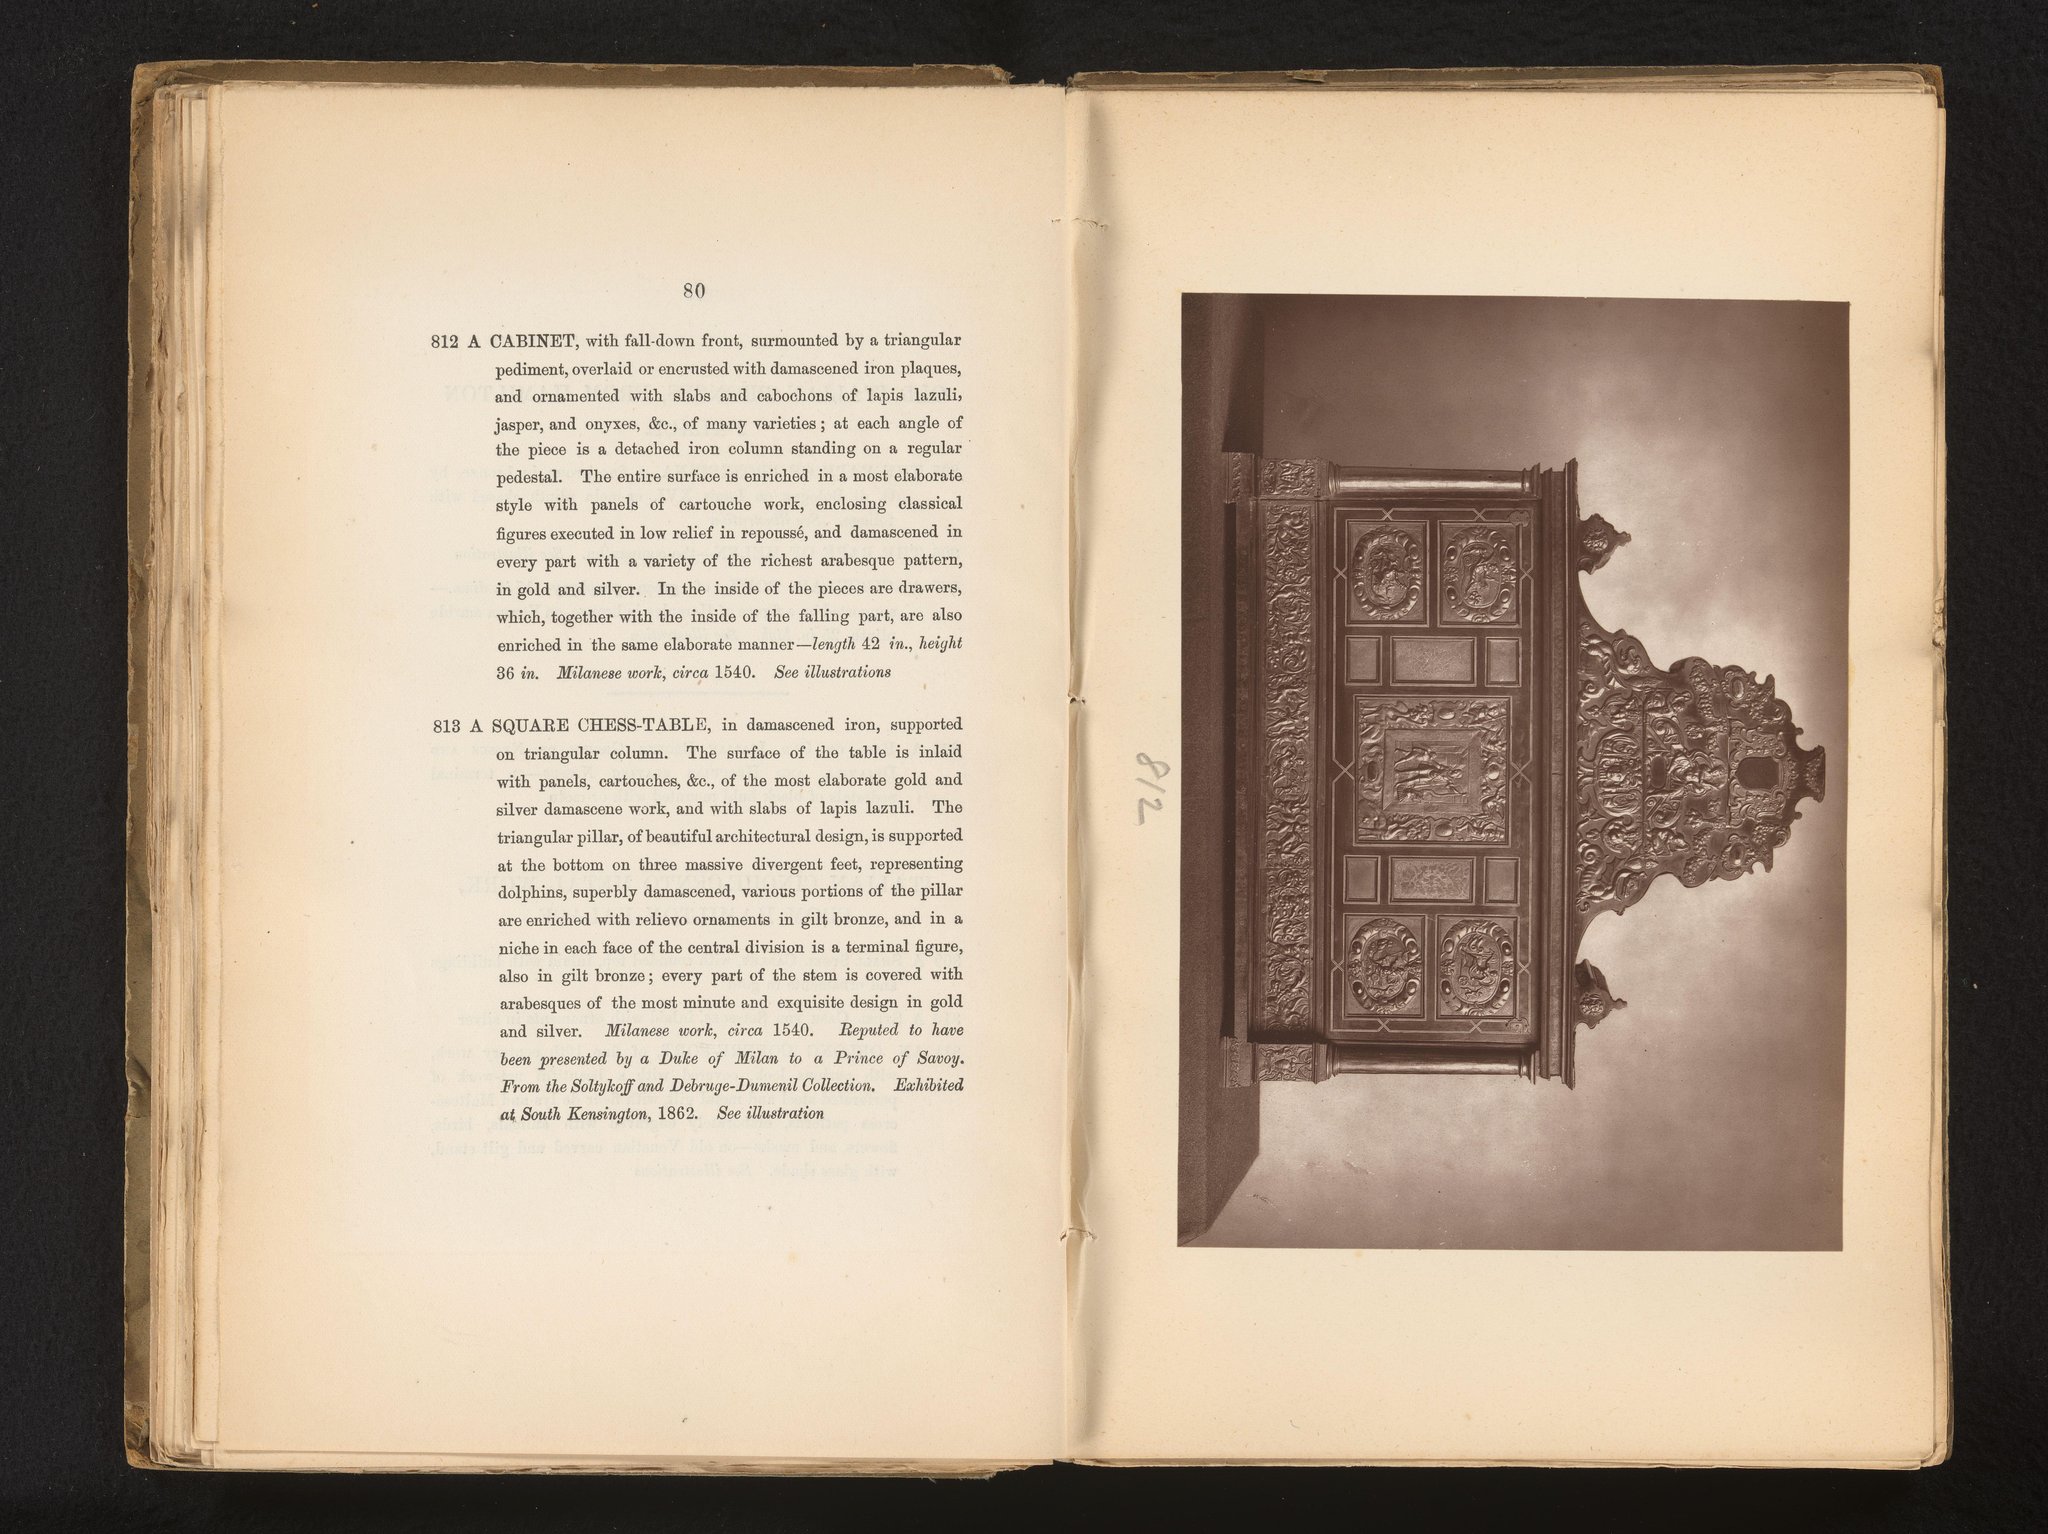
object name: page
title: Kabinet gedecoreerd met metaal, uit de collectie van Christopher Beckett Denison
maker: Anonymous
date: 1880-1885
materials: paper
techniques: woodburytype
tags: ornamental cupboard (+ wood and other phytogenic material)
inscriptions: number: ‘812’